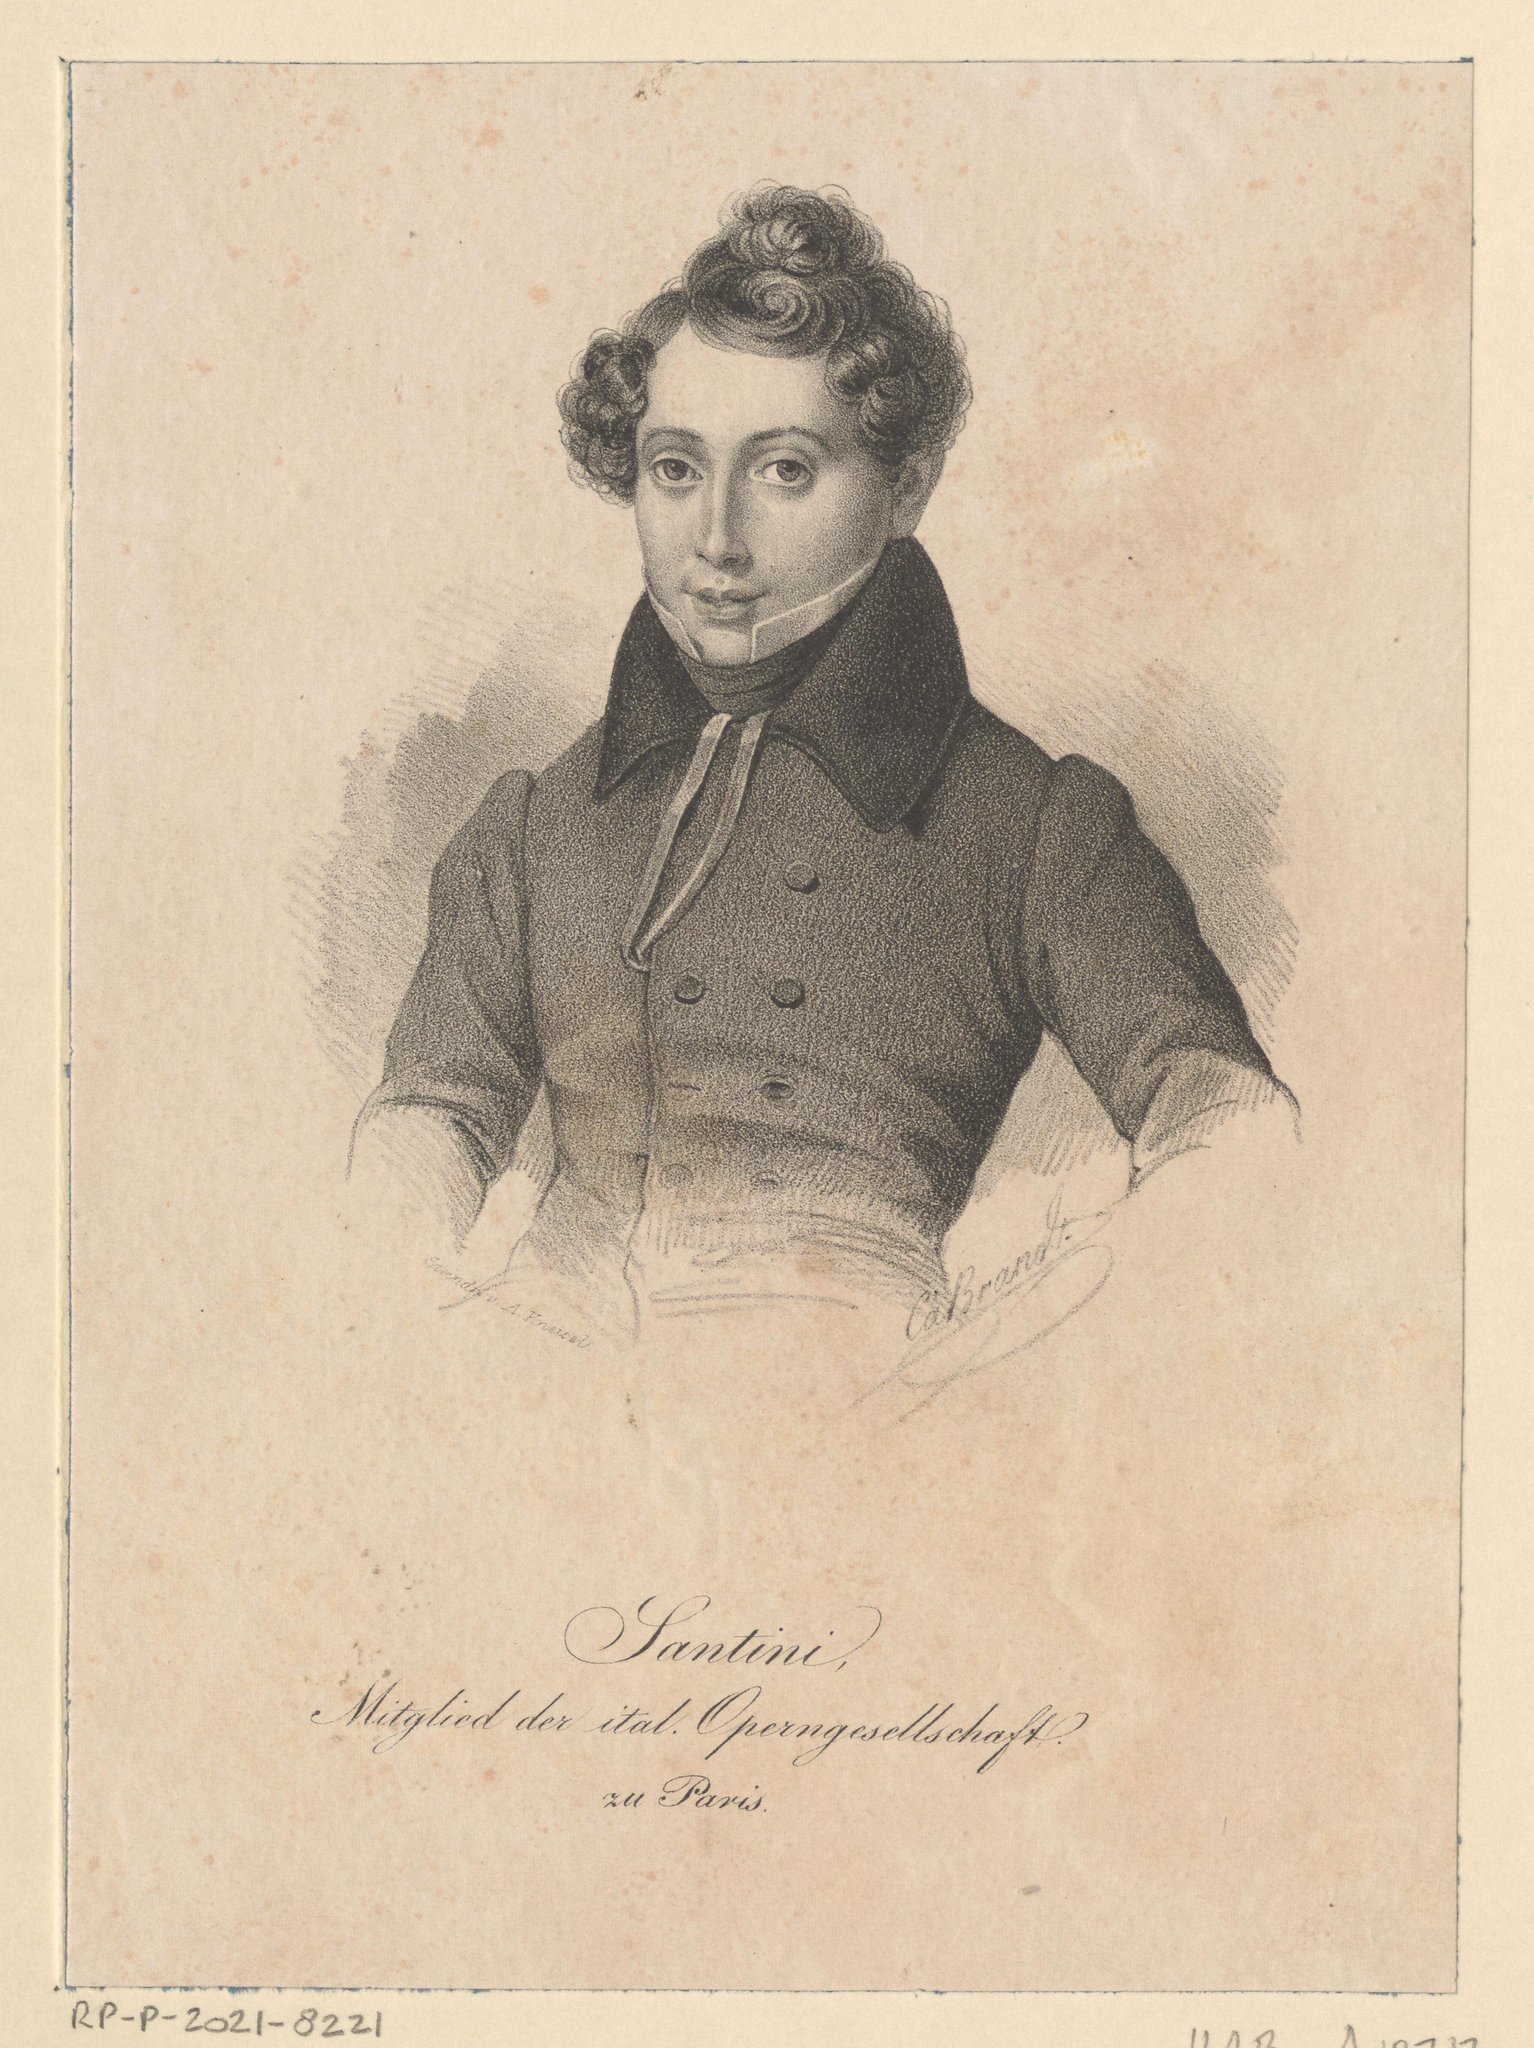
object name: print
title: Portret van Vincenzo Felice Santini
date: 1829-1855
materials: paper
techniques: lithograph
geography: leipzig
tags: historical persons, portrait of opera-singer